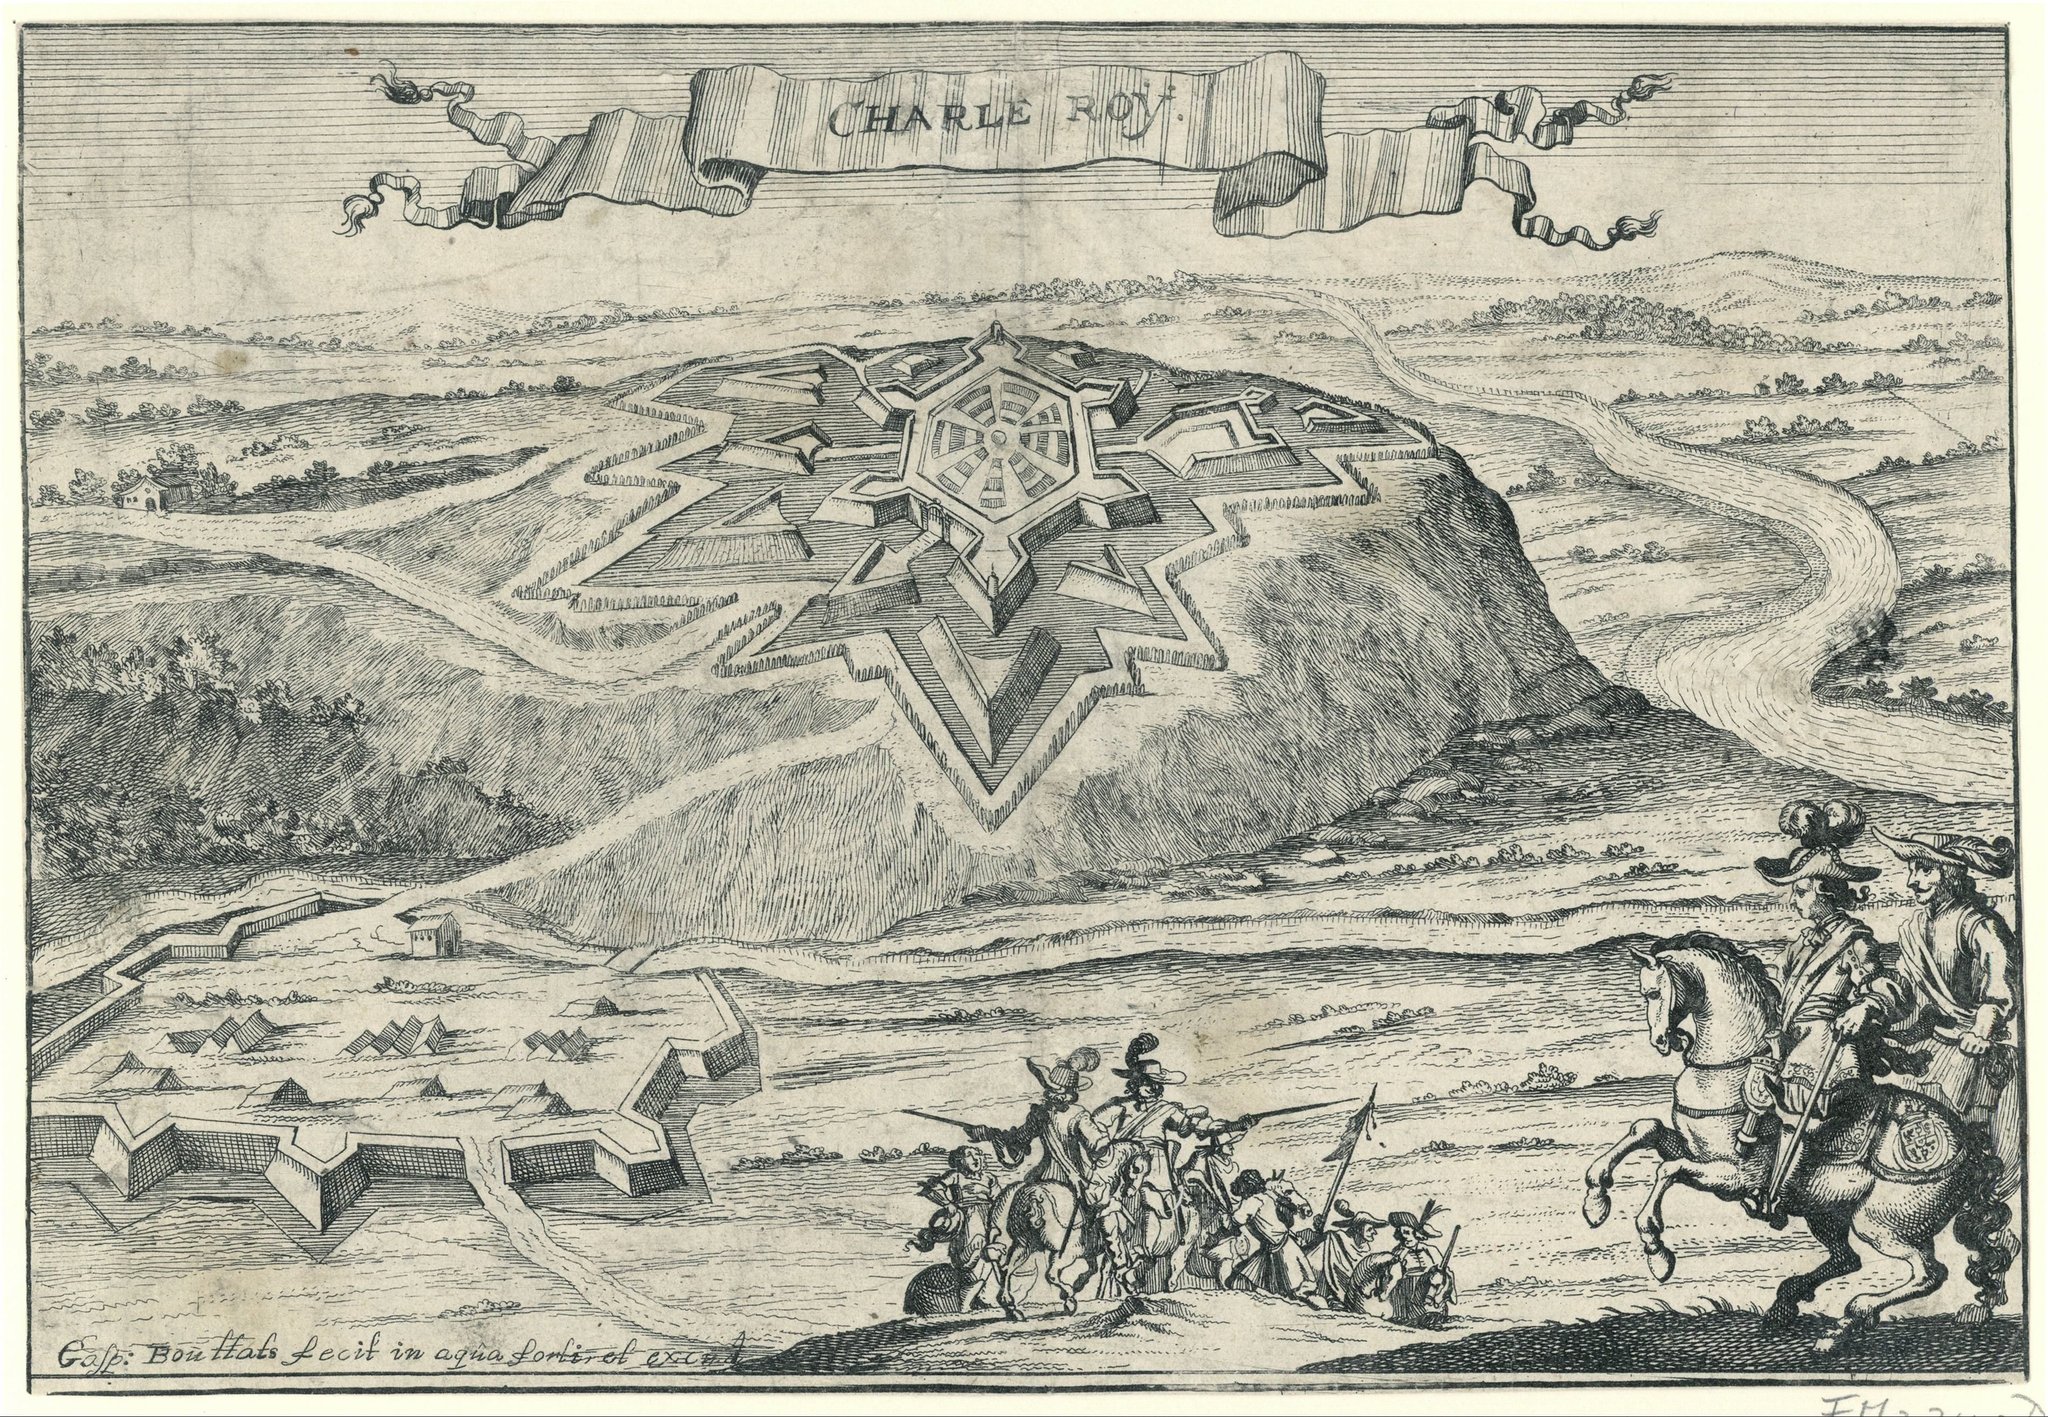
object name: print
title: Twaalf gezichten op vestingen en steden ingenomen door de Fransen en de bisschop van Munster in 1672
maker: gaspar bouttats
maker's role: print maker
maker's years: 1640-1695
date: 1672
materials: paper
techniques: etching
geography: antwerp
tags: fortress, rampjaar (disaster year)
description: Gezicht op de vesting te Charleroi. Op de voorgrond enige militairen. Deze prent maakt deel uit van een groep van twaalf prenten, merendeels geëetst en uitgegeven door Gaspar Bouttats, met gezichten op vestingen en steden veroverd door de Fransen en de bisschop van Munster in 1672.